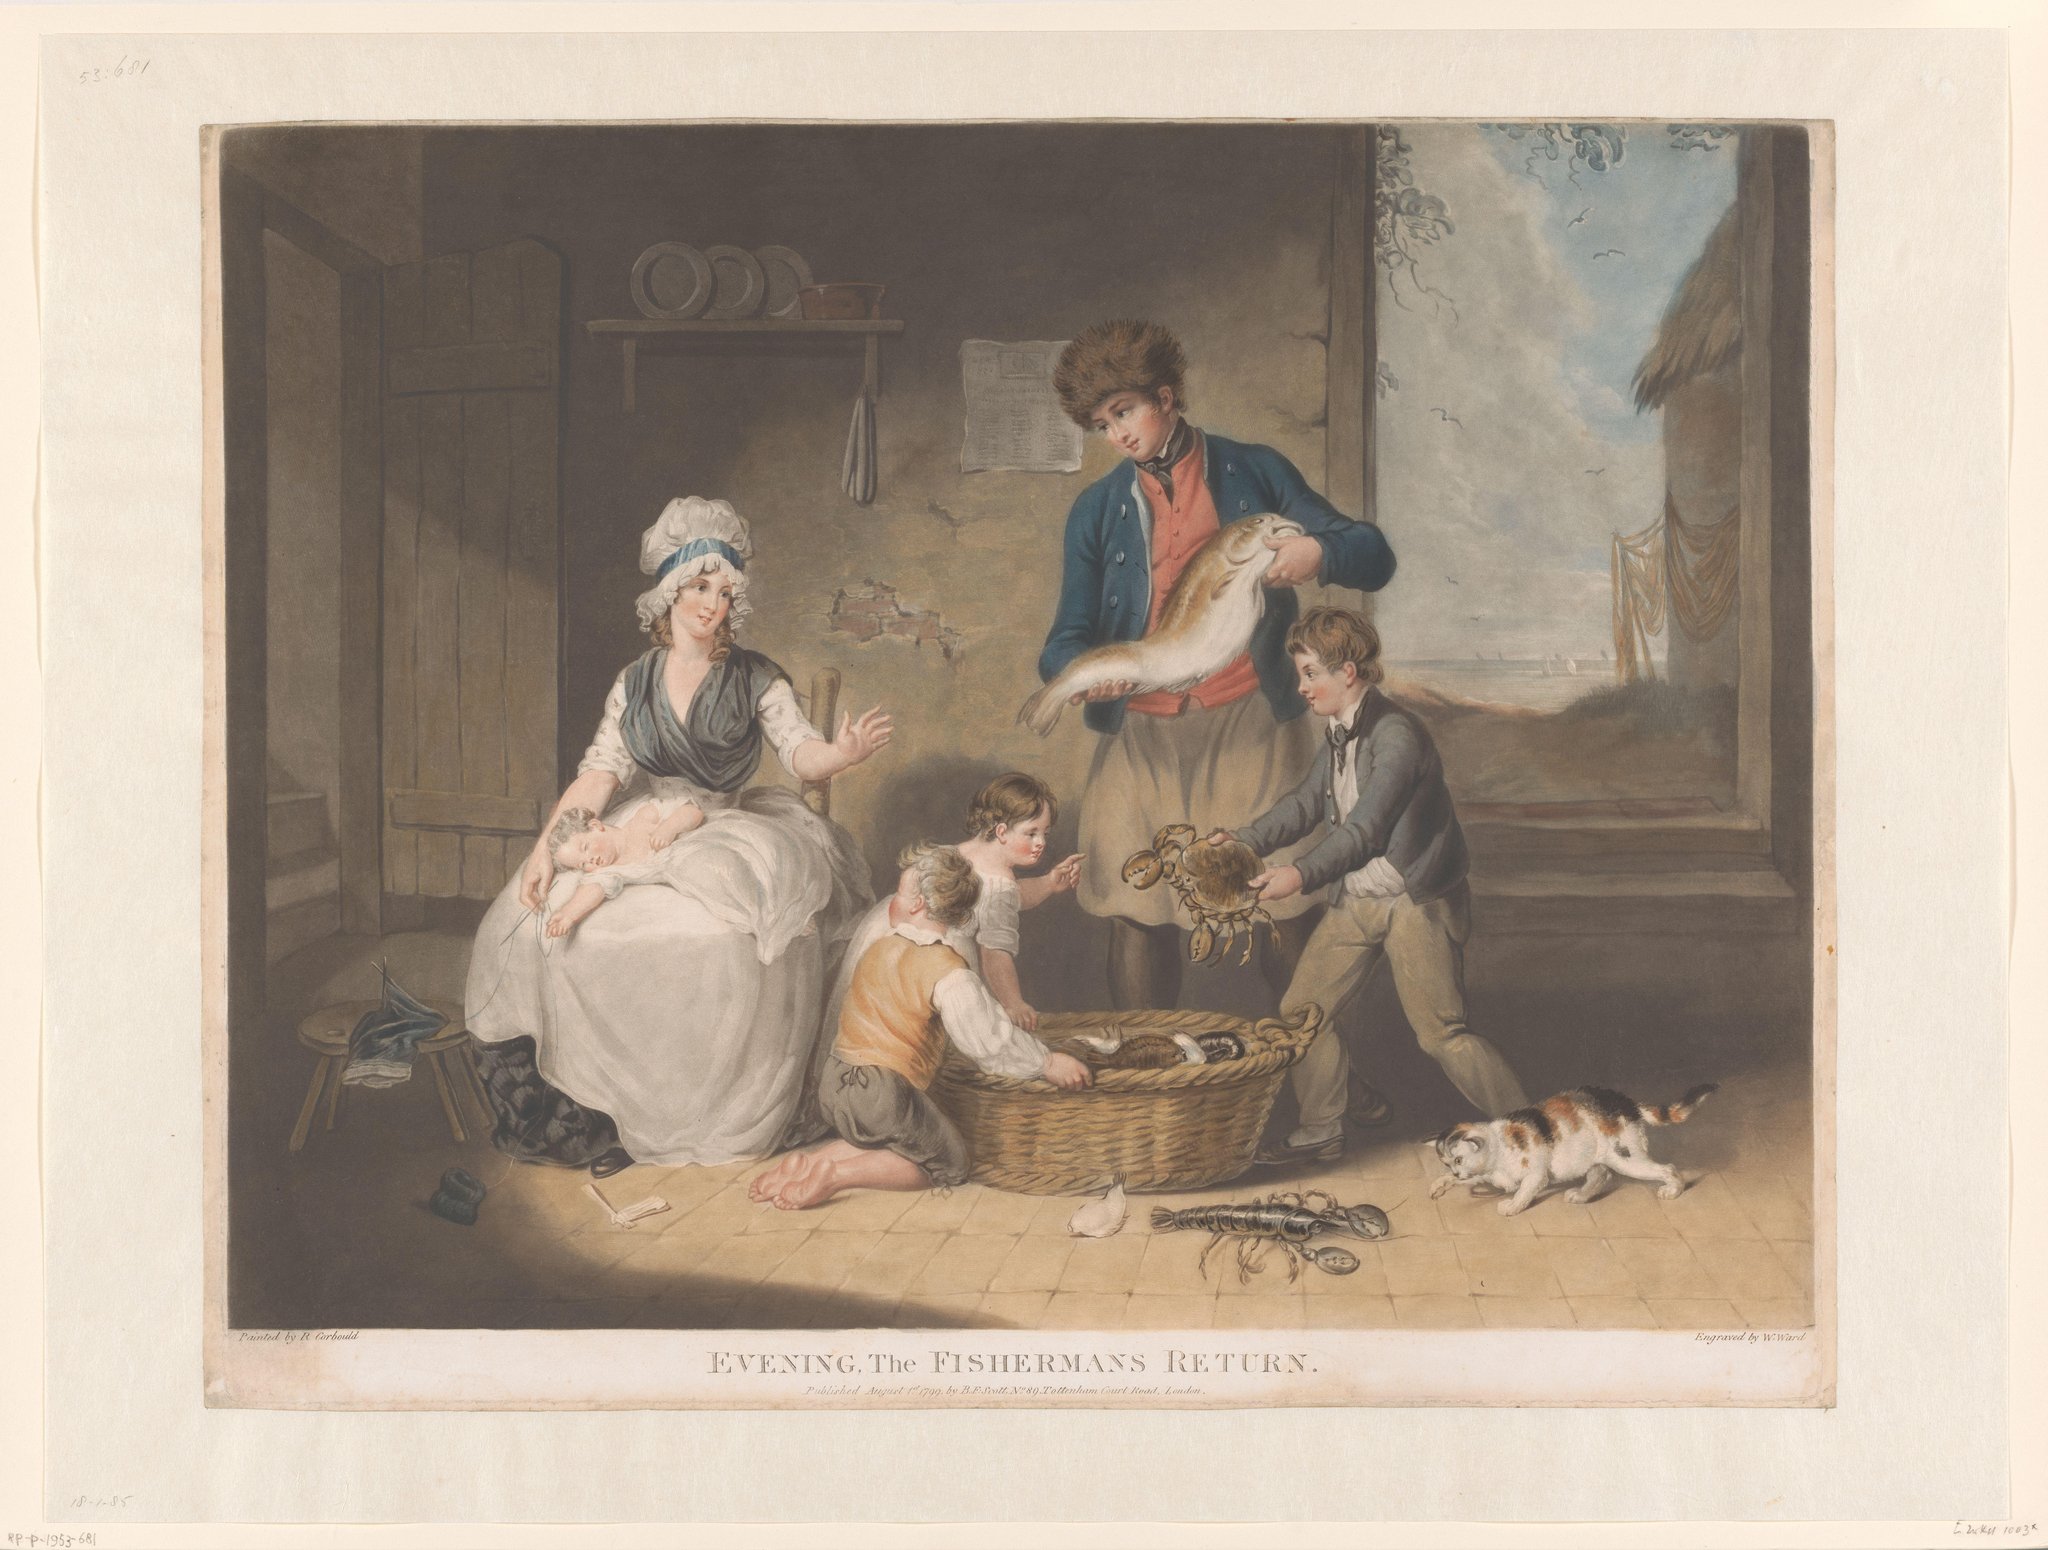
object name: print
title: Visser komt thuis met zijn vangst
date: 1799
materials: paper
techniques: hand coloring, lithography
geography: london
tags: being welcomed ~ travelling, fisherman showing catch, family life at home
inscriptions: collector's mark: Lugt 2228